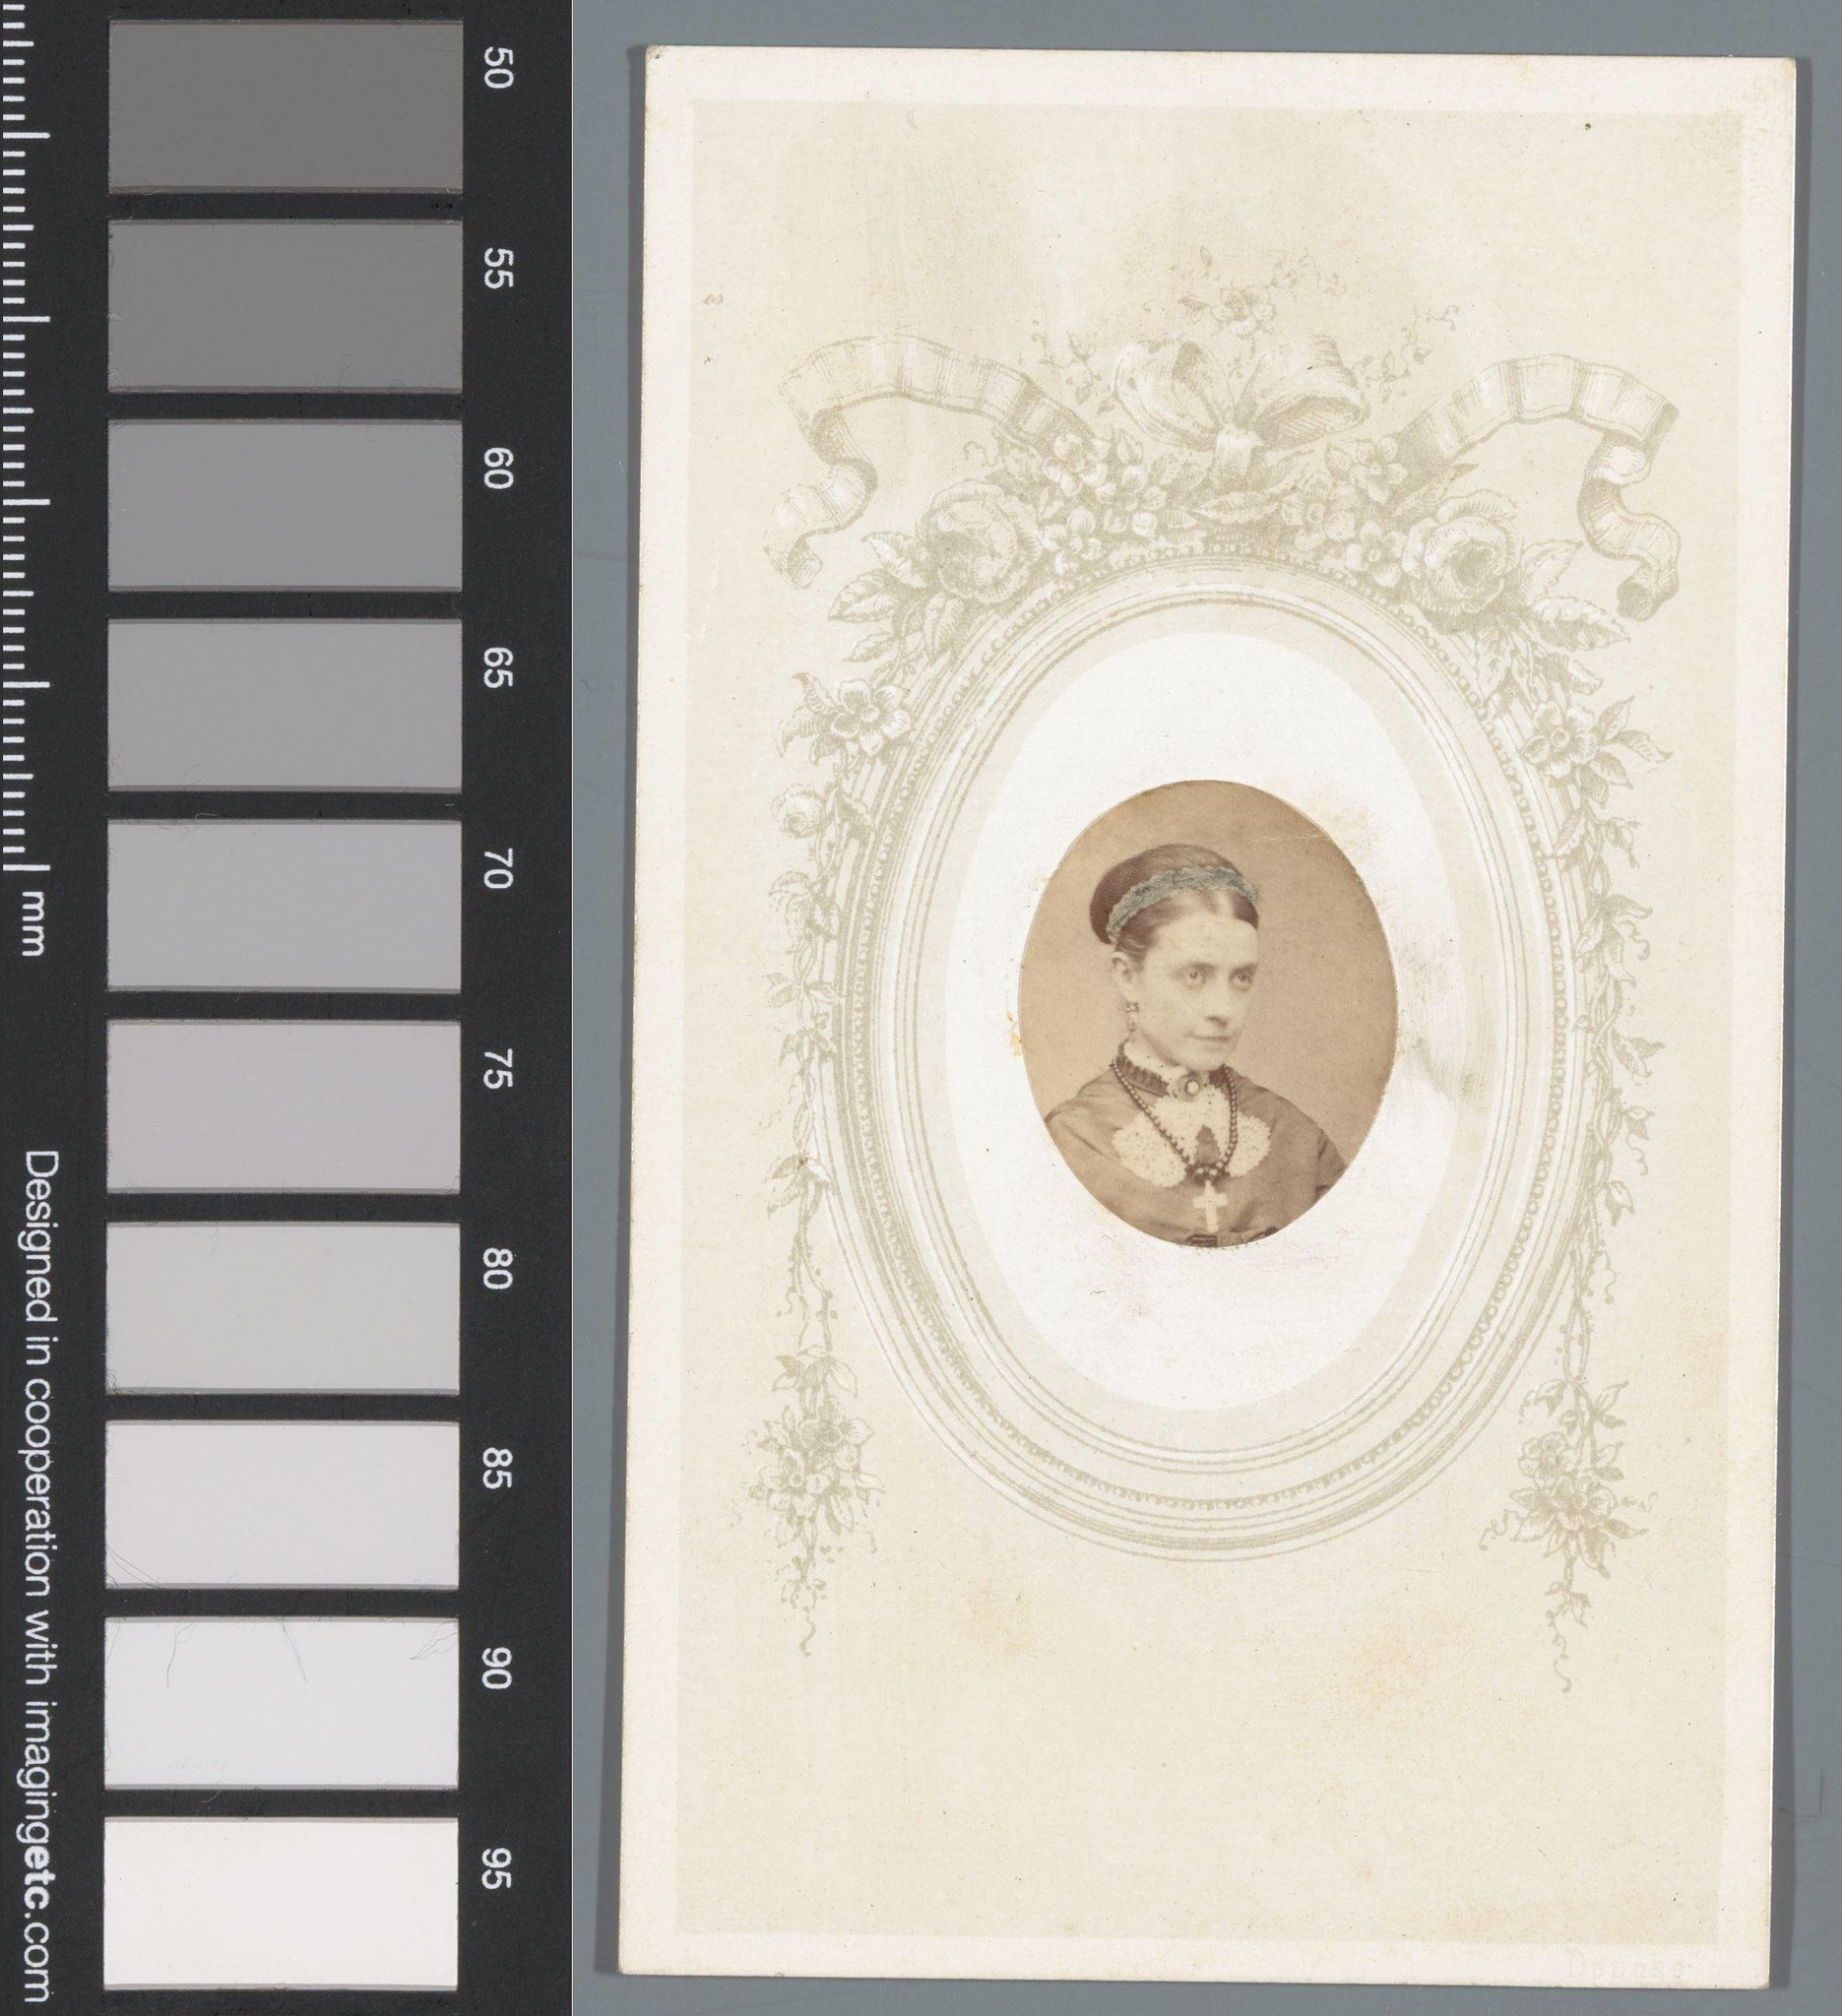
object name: carte de visite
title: Portret van een onbekende vrouw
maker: Anonymous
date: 1855-1885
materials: cardboard, paper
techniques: albumen print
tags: historical persons - bb - woman